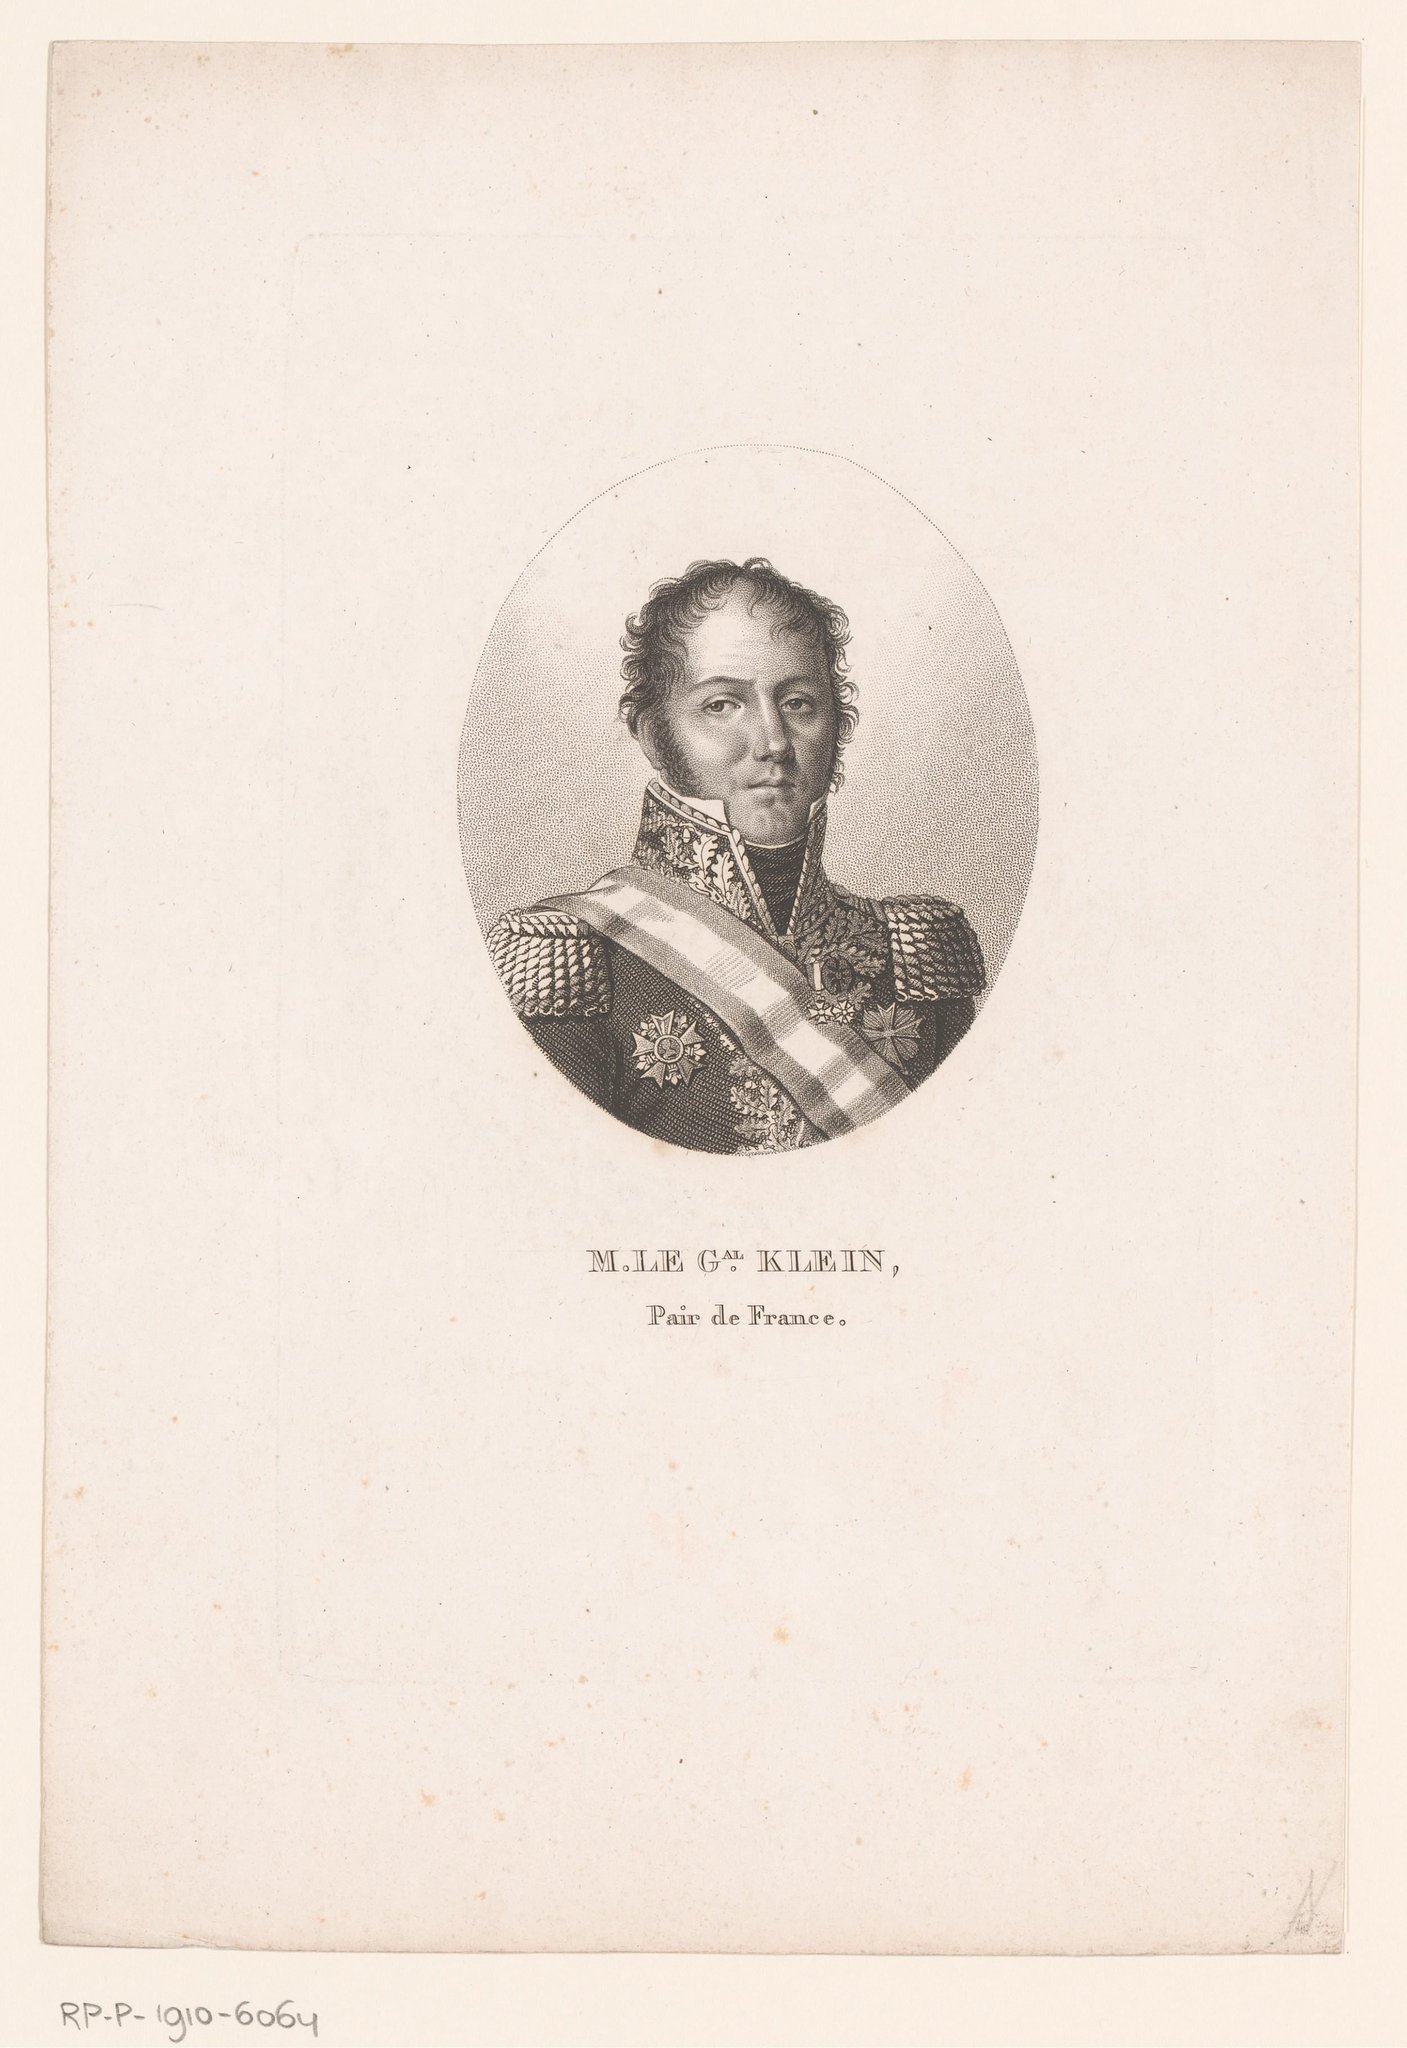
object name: print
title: Portret van Louis Klein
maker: ambroise tardieu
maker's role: print maker, printer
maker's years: 1788-1841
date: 1820-1821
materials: paper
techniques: engraving, roulette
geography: paris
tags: paris, historical persons, politician, e.g. party leader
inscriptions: collector's mark: Lugt 2228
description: Prent uit: Tardieu, Ambroise. Portraits des députés, écrivains et pairs constitutionnels, défenseurs invariables de la charte et de la loi des élections du 5 février 1817. Parijs: Tardieu, Ambroise, 1820-1821.